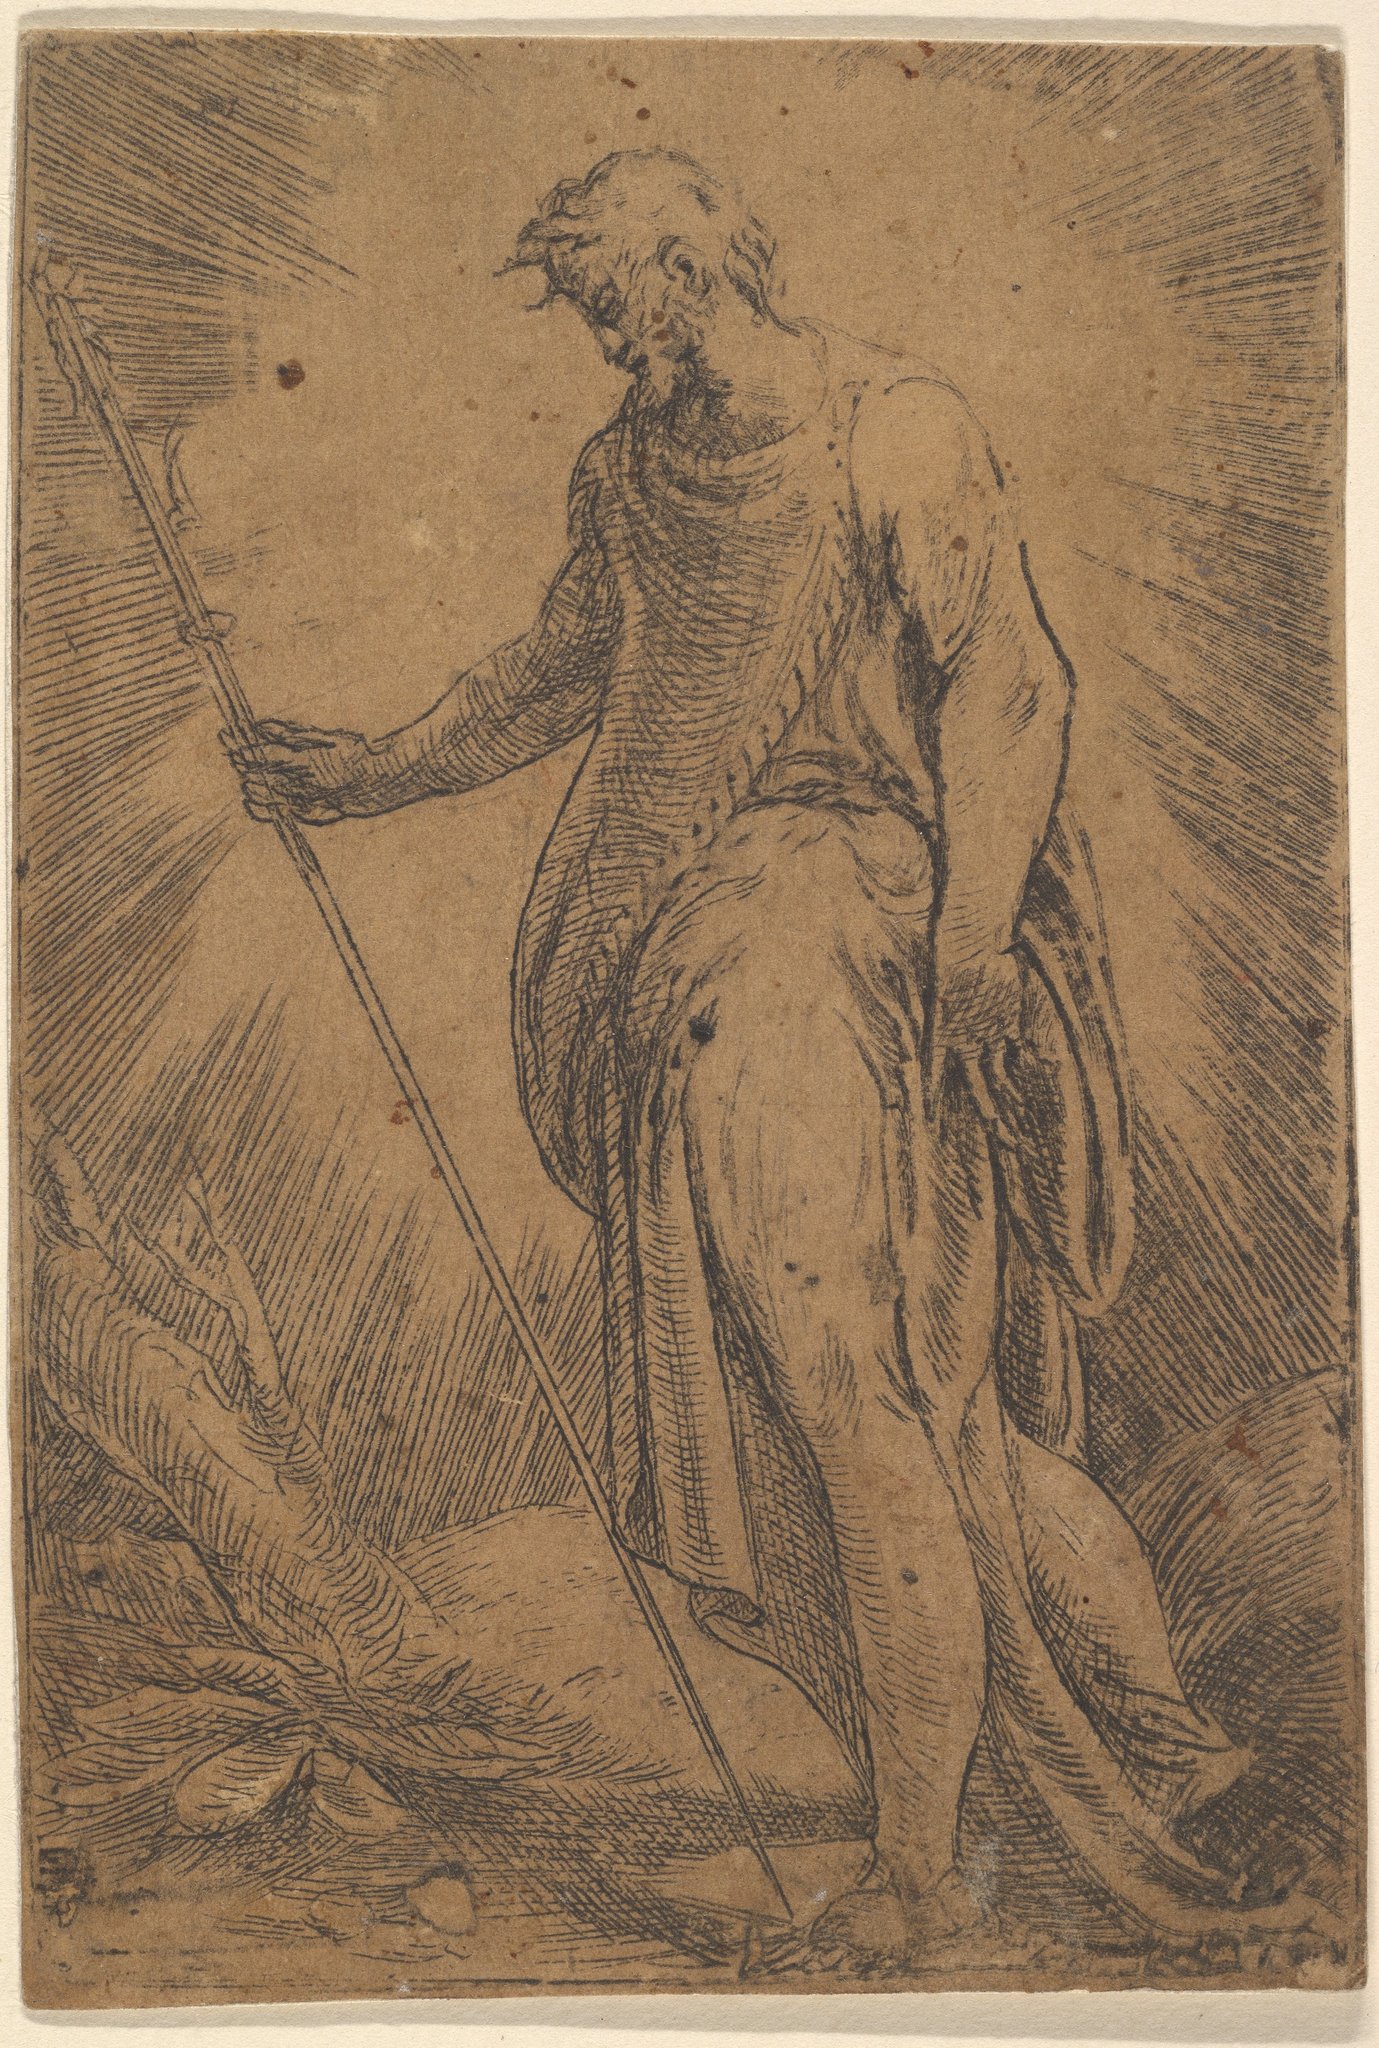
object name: print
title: An apostle holding a staff facing left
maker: andrea schiavone (andrea meldola)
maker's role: artist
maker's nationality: italian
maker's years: 1510-1563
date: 1540-1560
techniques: etching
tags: apostles